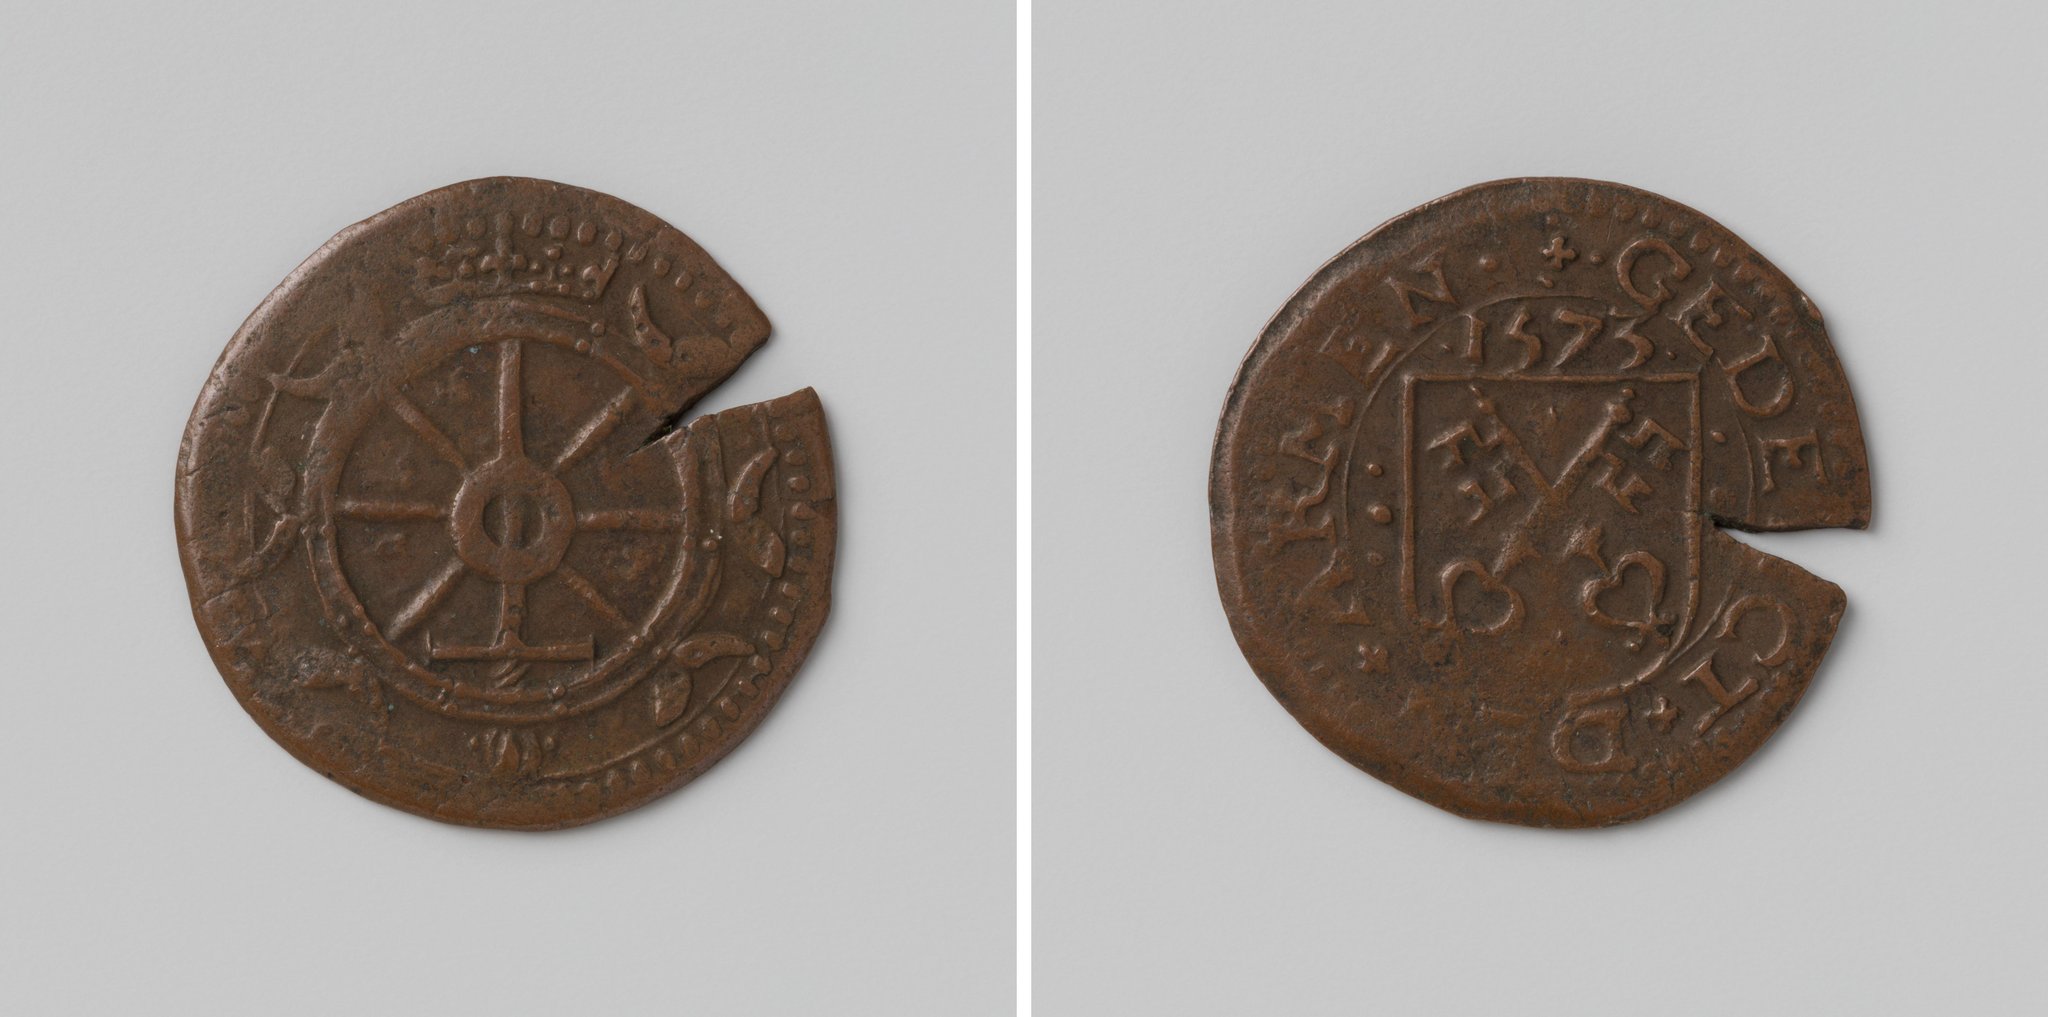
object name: oord, oortje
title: Catharina-gasthuis van Leiden, armenpenning ter waarde van een oord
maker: Anonymous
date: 1573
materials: copper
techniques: striking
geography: leiden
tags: leiden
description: Koperen penning. Voorzijde: gekroond rad. Keerzijde: wapenschild onder jaartal binnen omschrift.